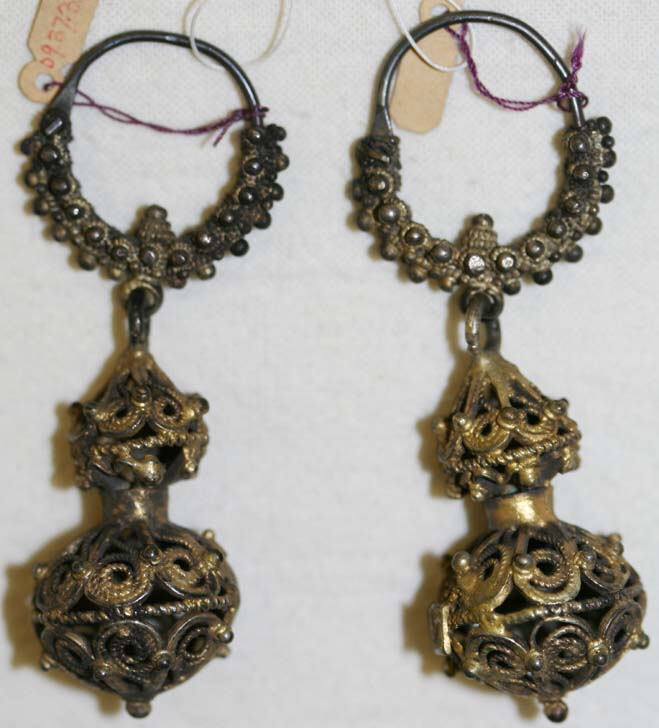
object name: earring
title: Earrings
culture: european, eastern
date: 1701-1900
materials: metal